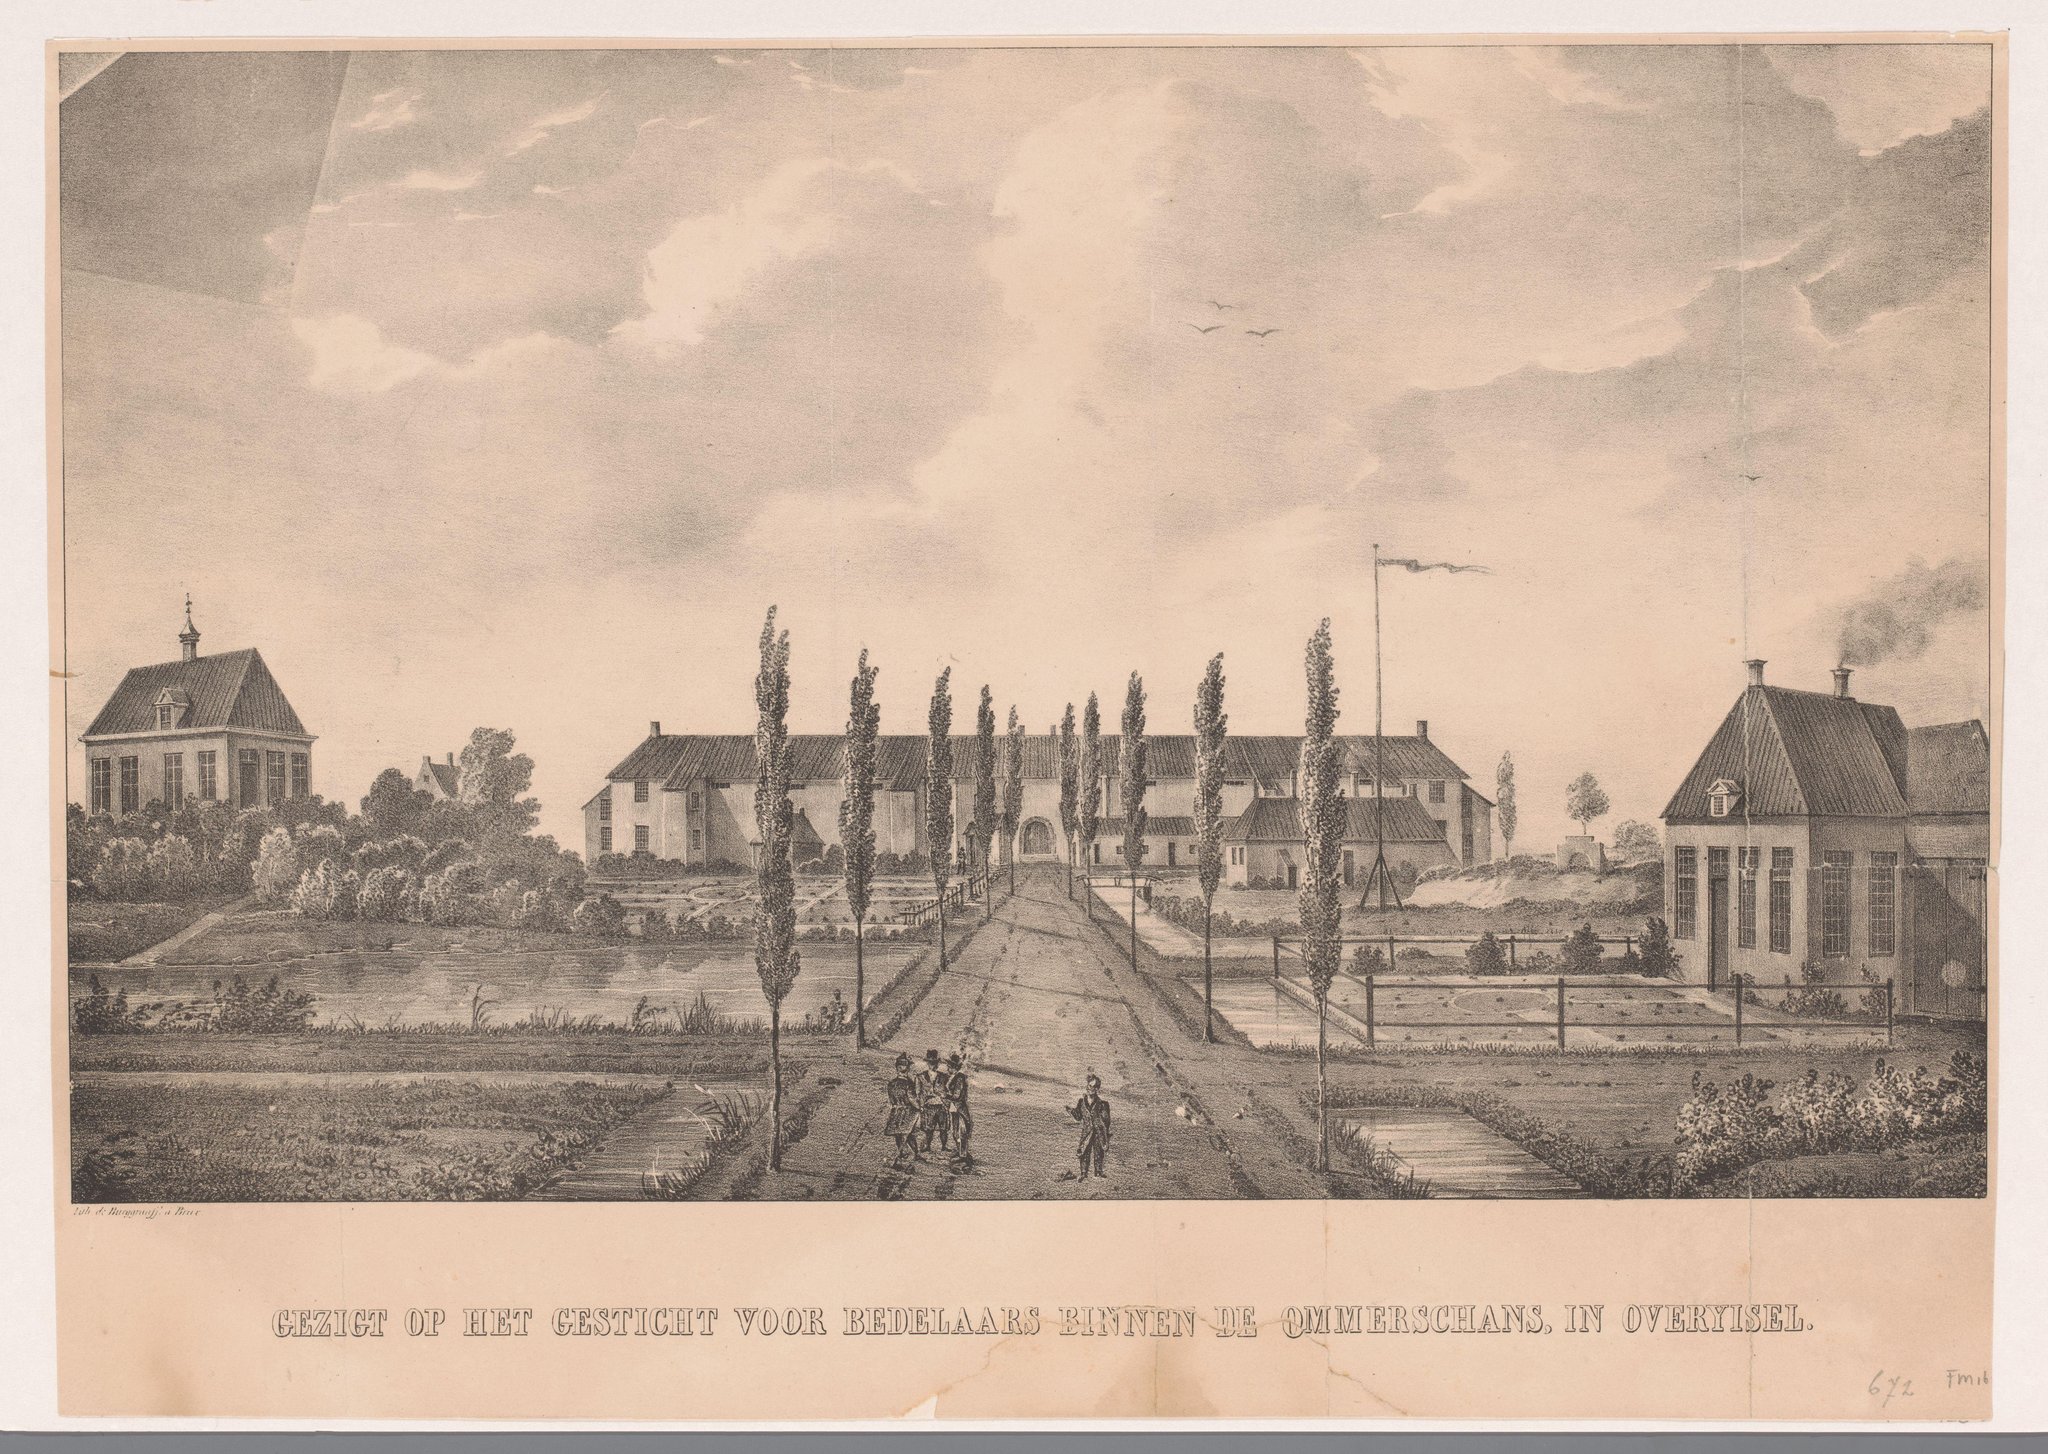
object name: print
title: Gesticht voor bedelaars binnen de Ommerschans (voorzijde), 1819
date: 1825-1835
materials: paper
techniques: lithograph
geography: netherlands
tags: maatschappij van weldadigheid, ommerschans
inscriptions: collector's mark: Lugt 2228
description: Gezicht op het gesticht voor bedelaars binnen de Ommerschans (voorzijde), in Overijssel, opgericht door de Maatschappij van Weldadigheid in 1819. Zie ook de pendant.